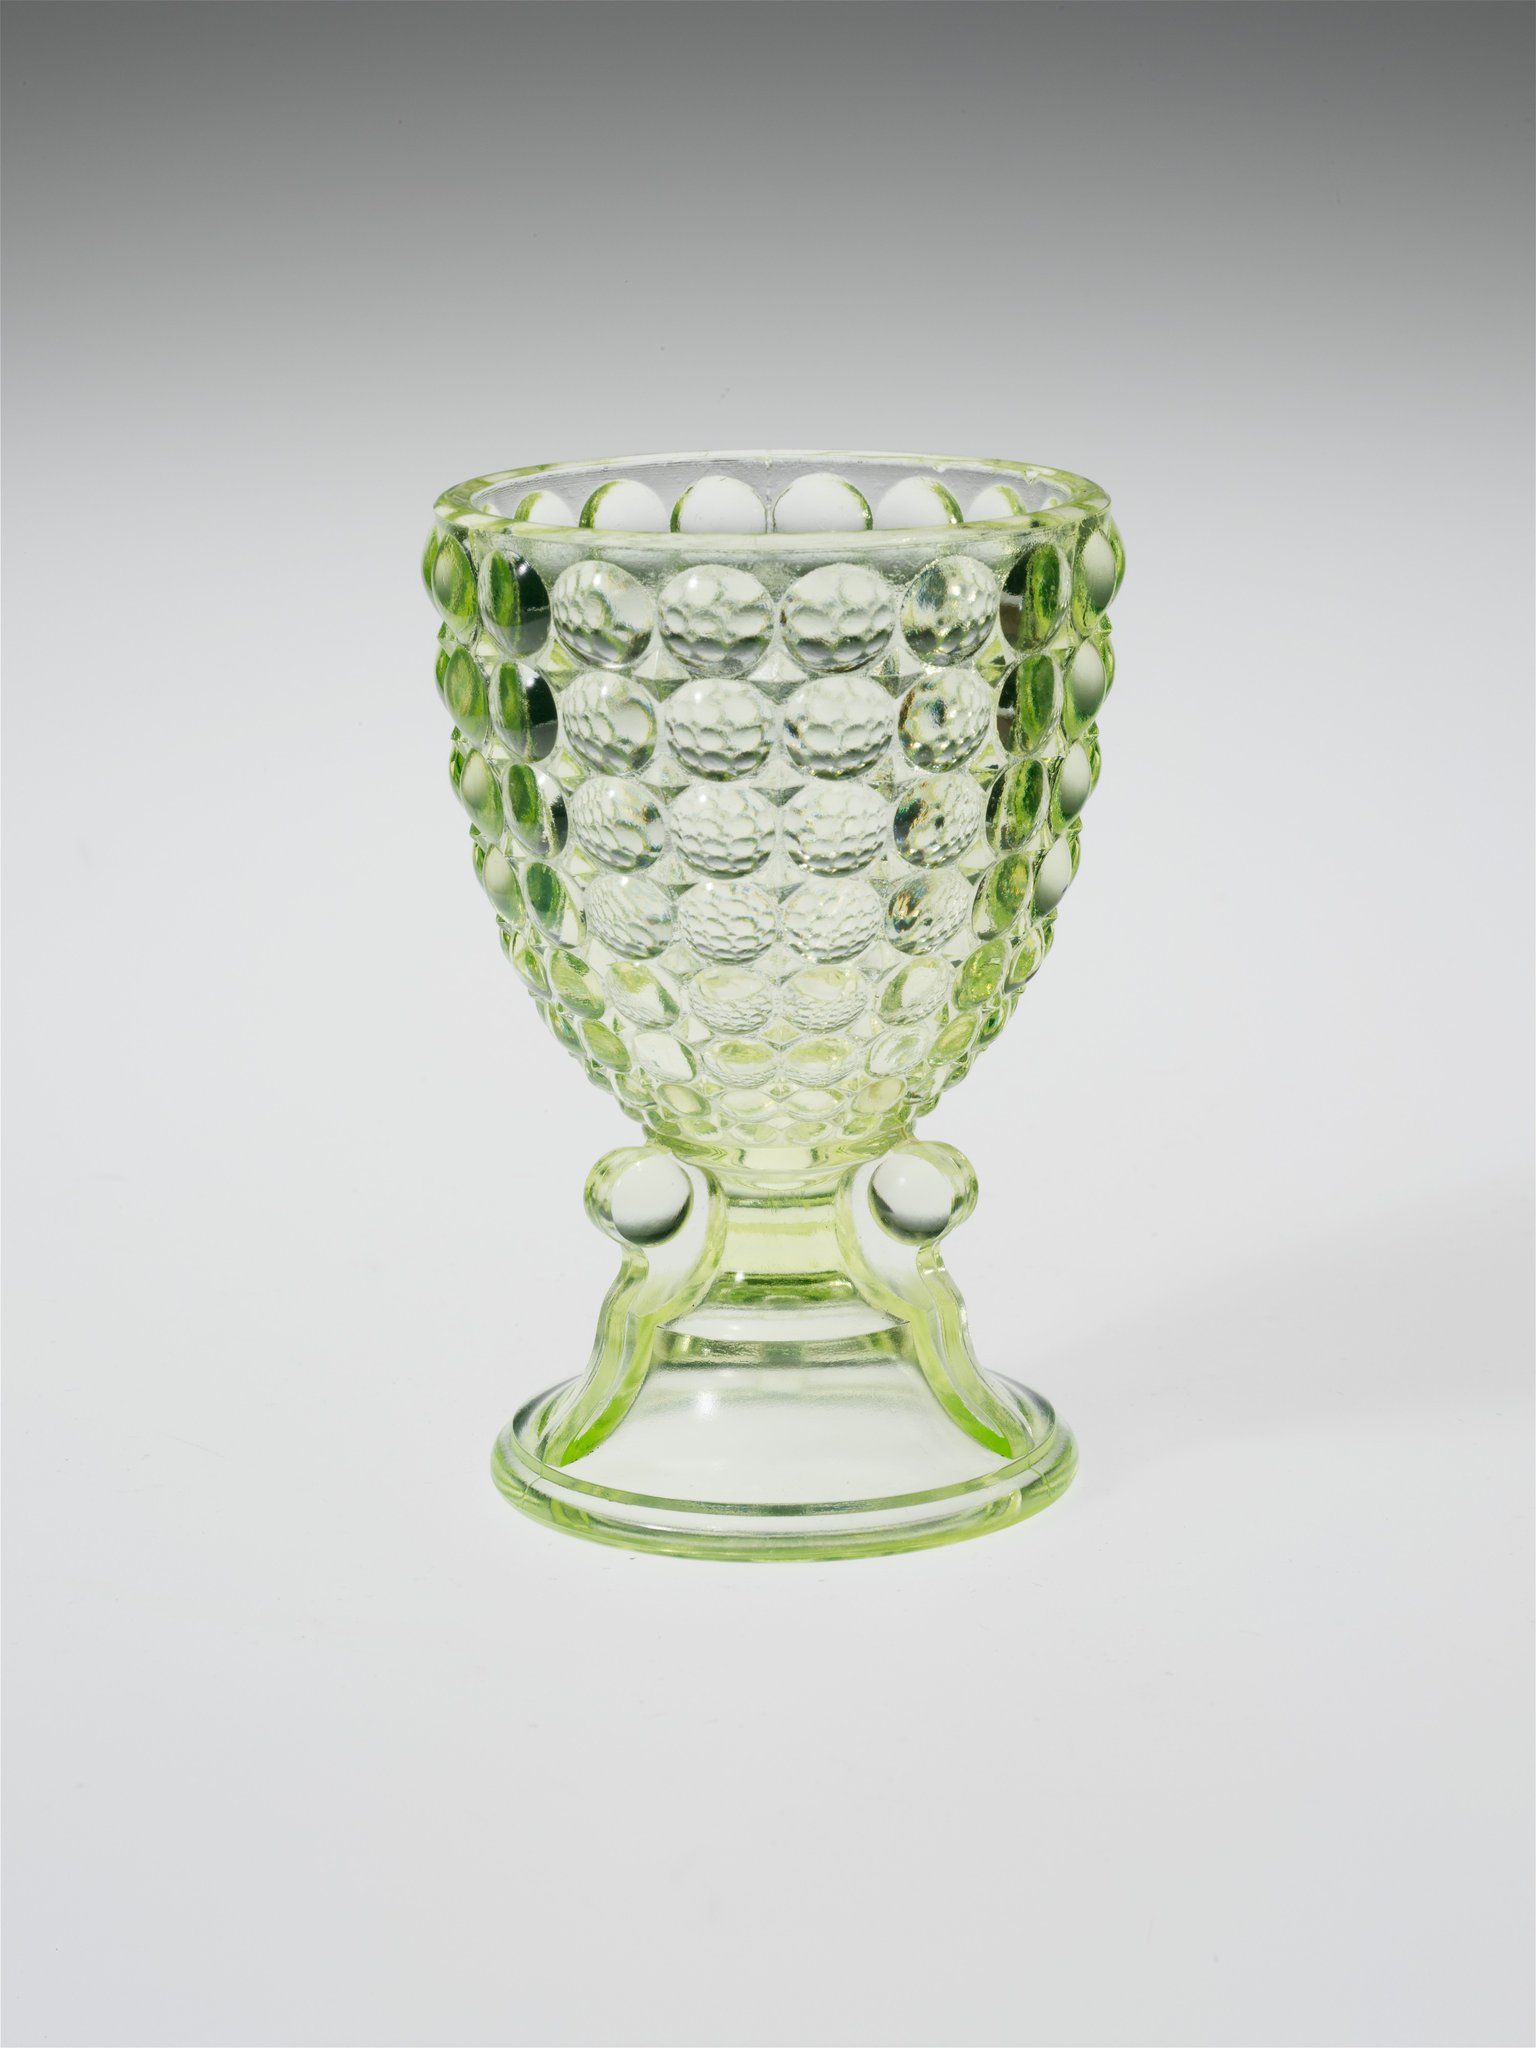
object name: egg cup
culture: american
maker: adams and company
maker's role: maker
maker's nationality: american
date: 1870-1880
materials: glass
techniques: pressed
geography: united states